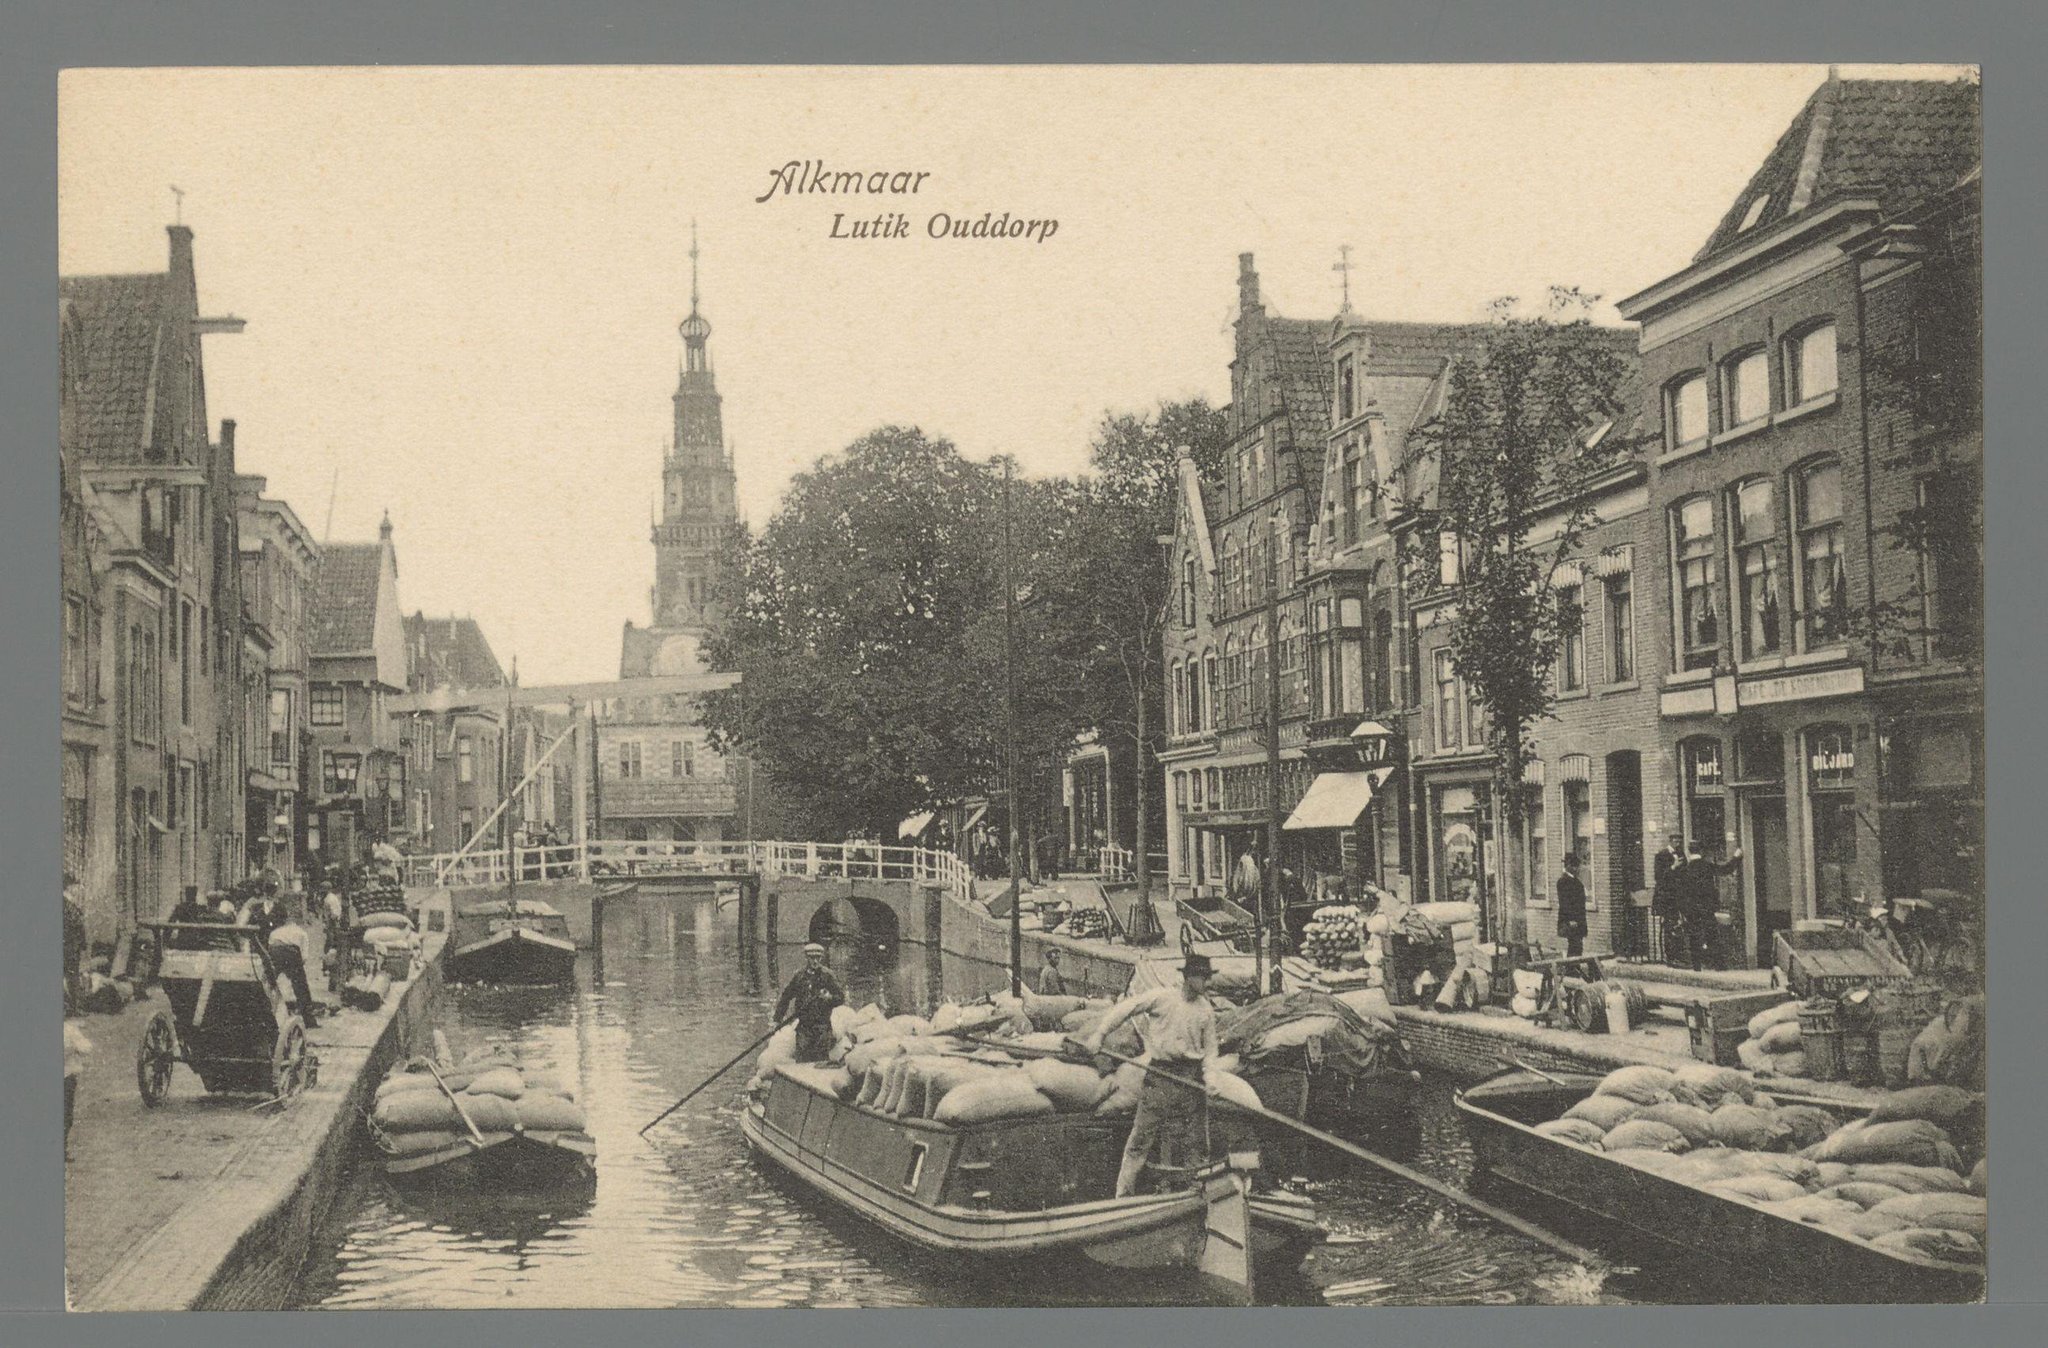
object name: ansichtkaart, prentbriefkaart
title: Alkmaar. Lutik Ouddorp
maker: Anonymous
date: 1909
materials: cardboard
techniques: photograph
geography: the hague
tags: city-view, and landscape with man-made constructions, sailing-ship, sailing-boat, tower, clock tower ~ monumental adornment, canals, waters (in city), bridge in city across river, canal, etc.